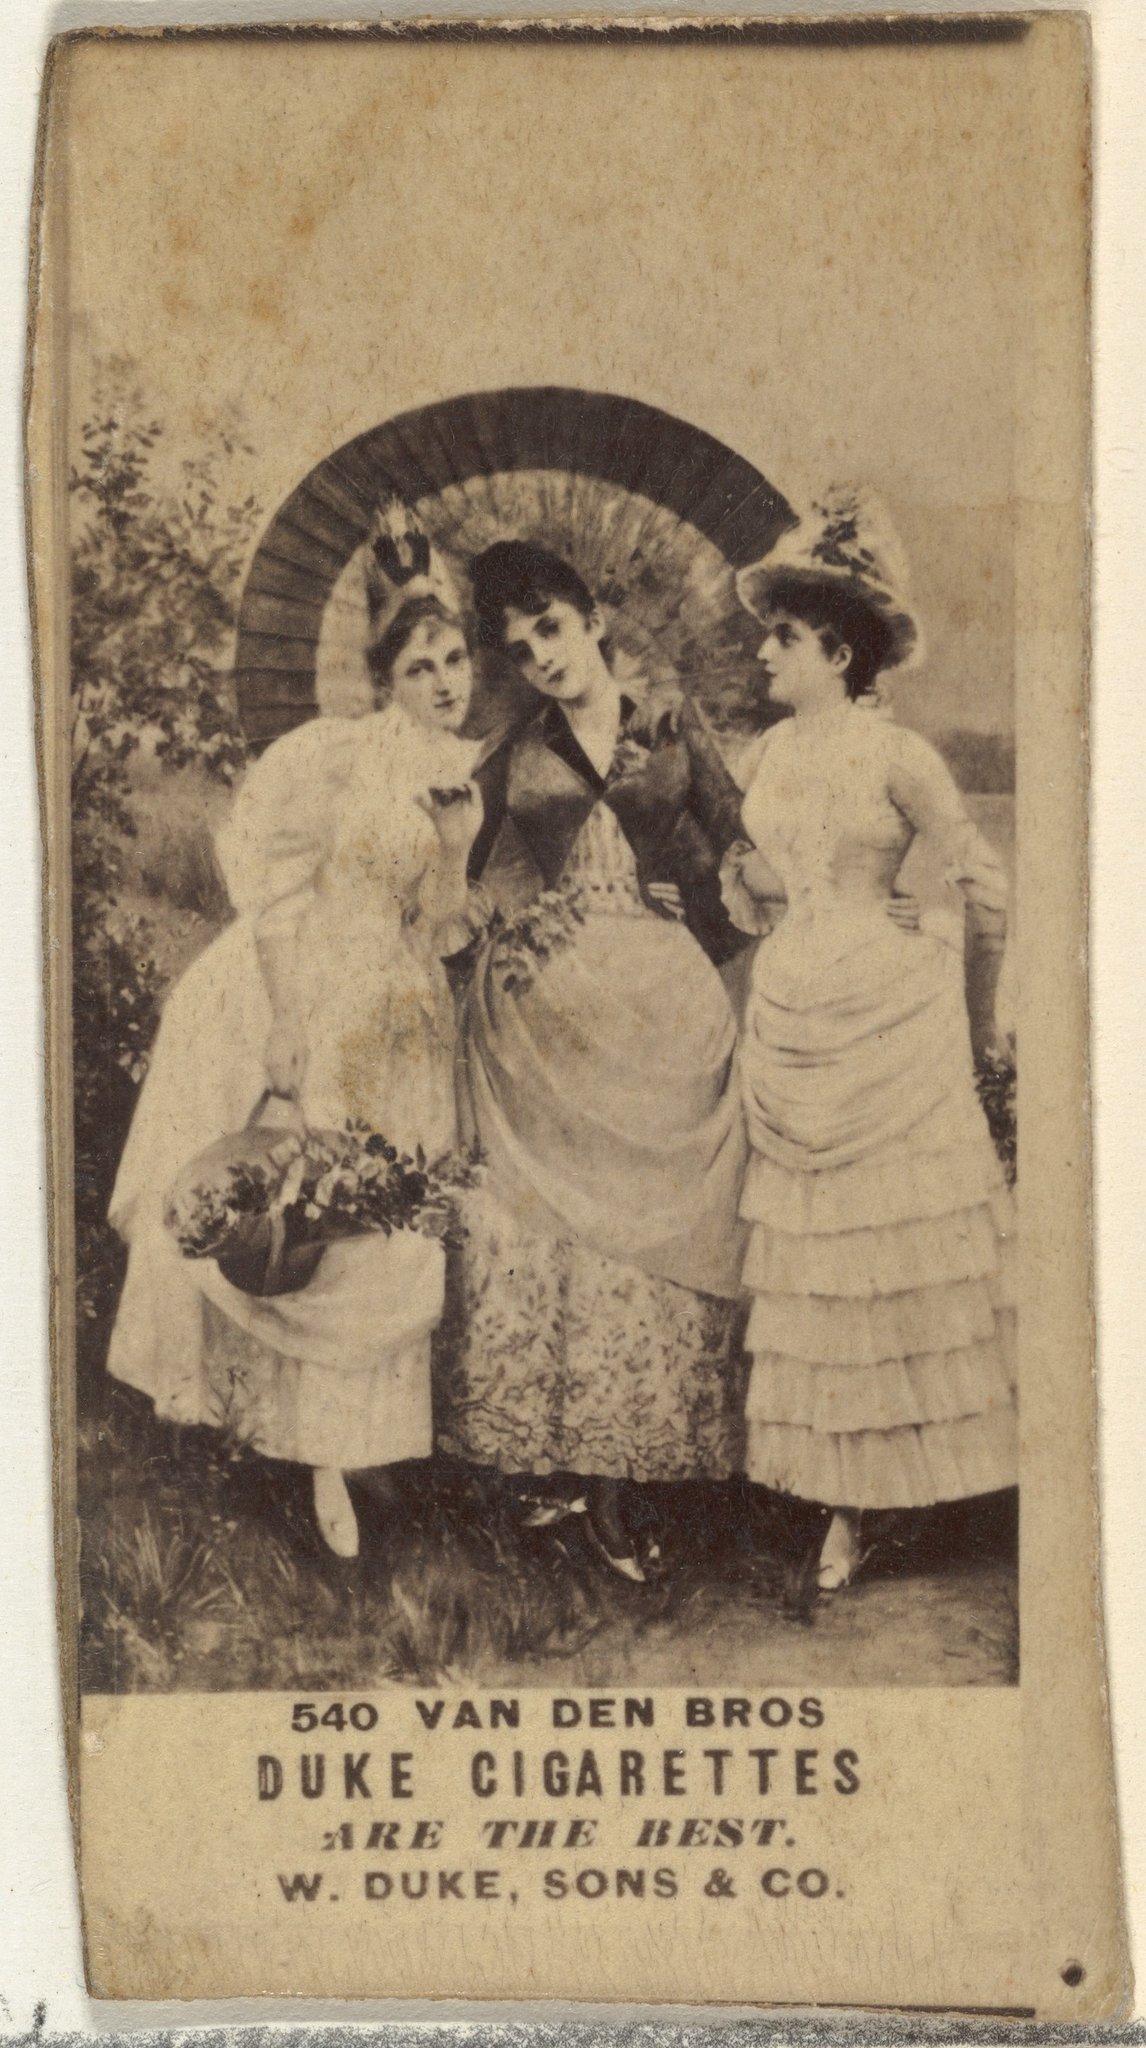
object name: photograph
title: Card Number 540, Van Den Bros., from the Actors and Actresses series (N145-7) issued by Duke Sons & Co. to promote Duke Cigarettes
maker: w. duke, sons & co.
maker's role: publisher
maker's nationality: american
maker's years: 1870-1920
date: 1880-1889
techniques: albumen silver print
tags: portraits,women,actresses